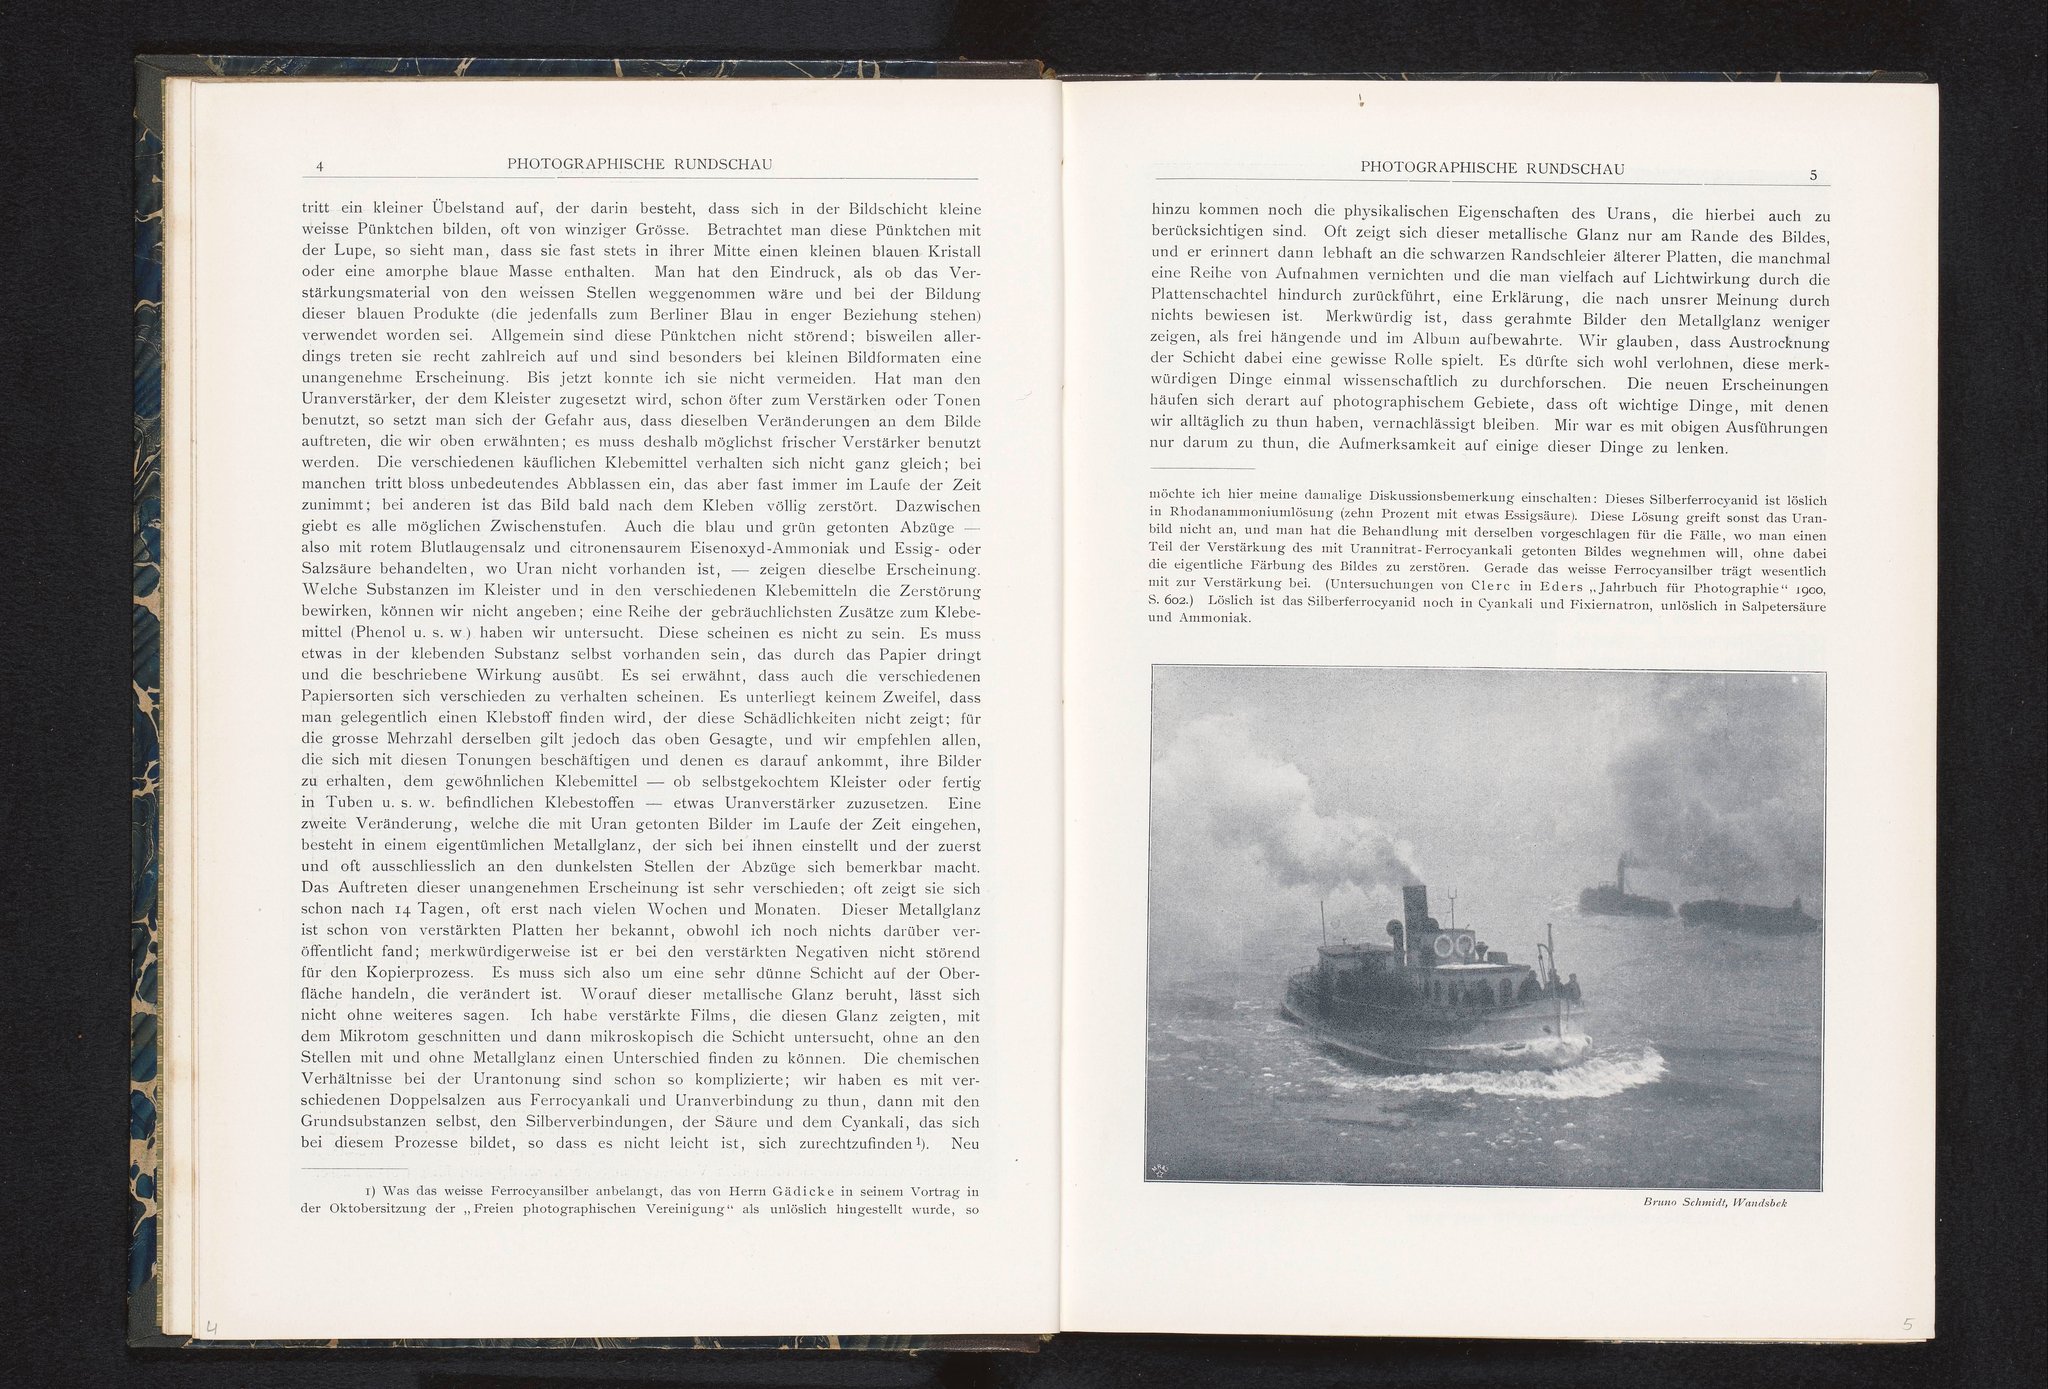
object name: page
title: Schepen op open water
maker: bruno schmidt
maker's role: fotograaf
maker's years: 1858-1919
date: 1896-1901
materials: paper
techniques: autotype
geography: berlin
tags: sea (seascape), steamship, motorship